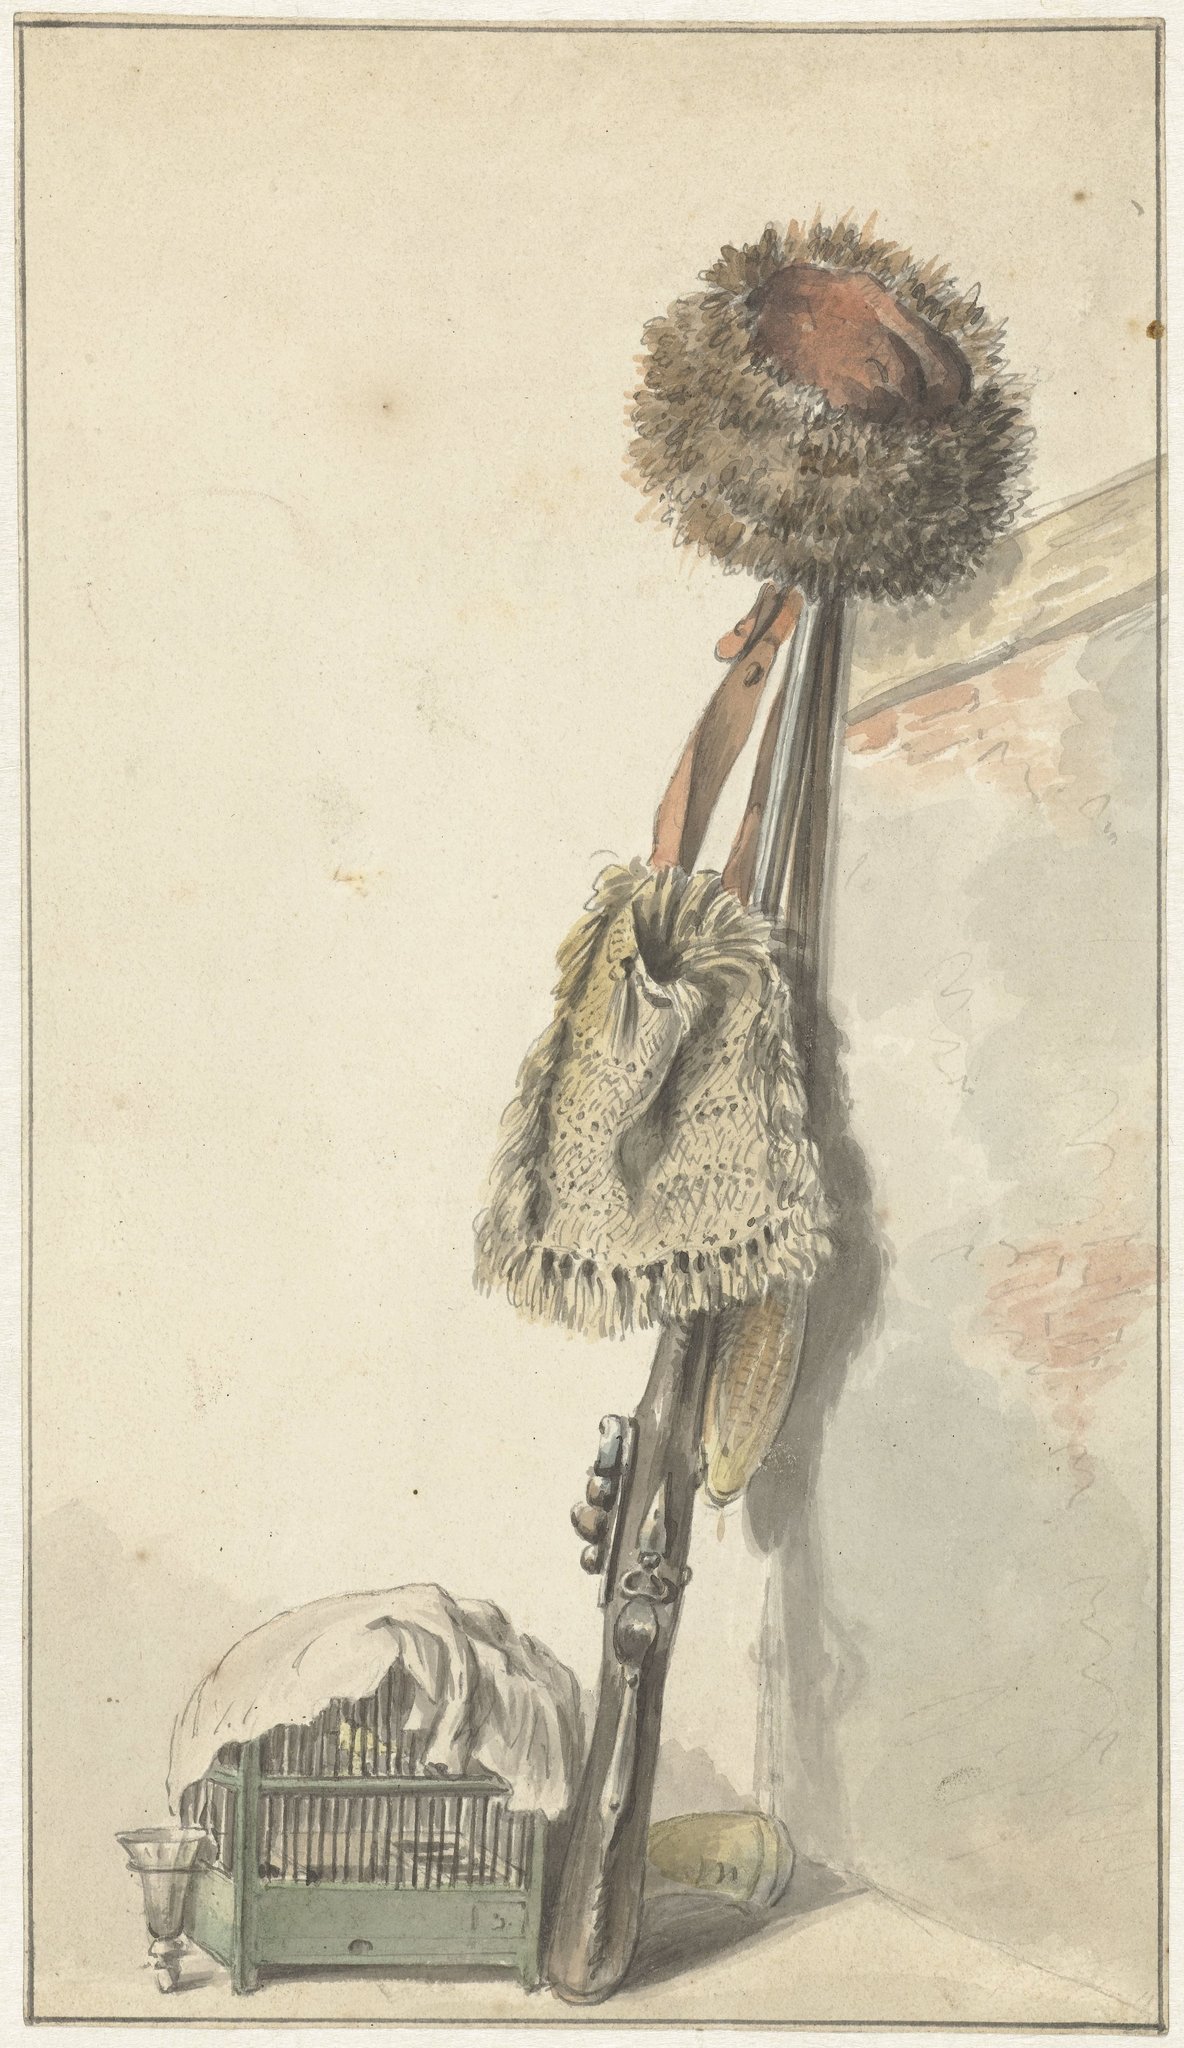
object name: watercolor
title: Jachtstilleven met vogelkooi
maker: jacob van strij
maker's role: draughtsman, painter, print maker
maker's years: 1756-1815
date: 1766-1815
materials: ink, paper, watercolor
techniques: brush, pen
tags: head-gear (fur cap) (+ men's clothes), hunting accoutrement, firearms: rifle, bird in a cage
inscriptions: inscription: ‘PG van Os’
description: Jachtstilleven met vogelkooi, geweer, kruithoorn, weitas en bontmuts.